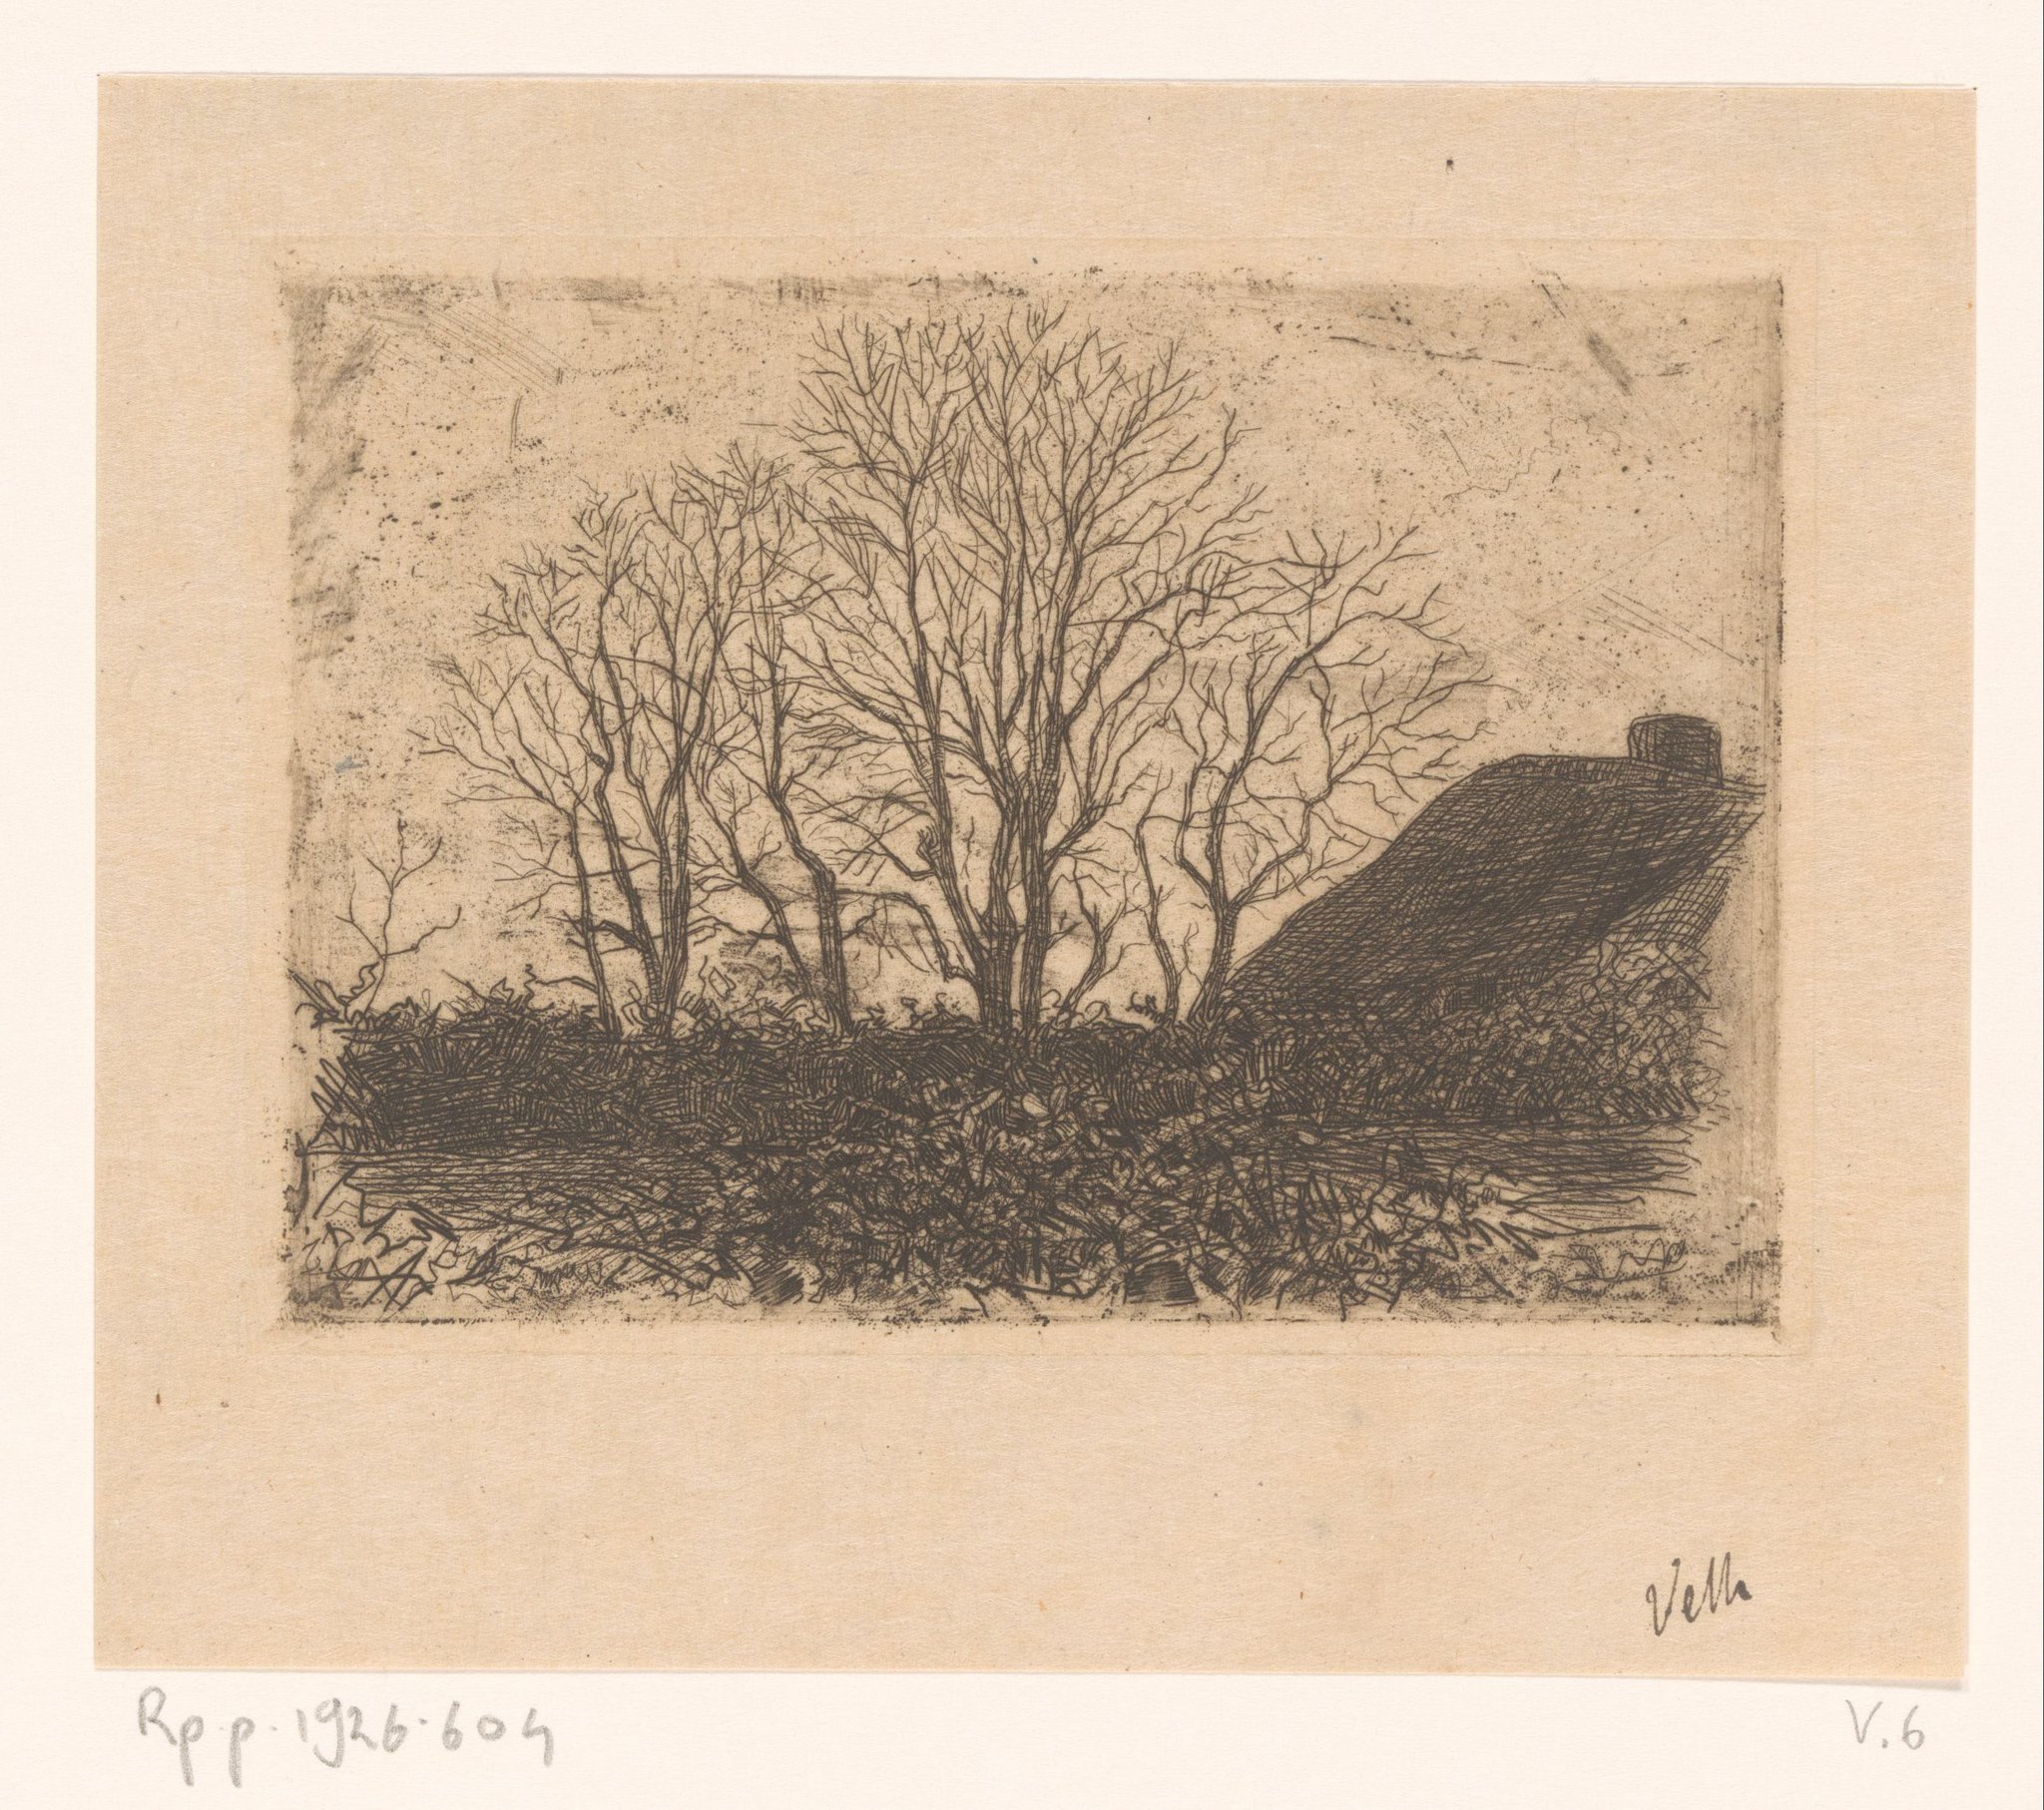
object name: print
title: Weide met bomen, Ewijkshoeve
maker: jan veth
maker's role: designer, draughtsman, painter, print maker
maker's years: 1864-1925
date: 1885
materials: paper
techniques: drypoint, etching, intaglio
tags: farm or solitary house in landscape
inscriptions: collector's mark: Lugt 2228